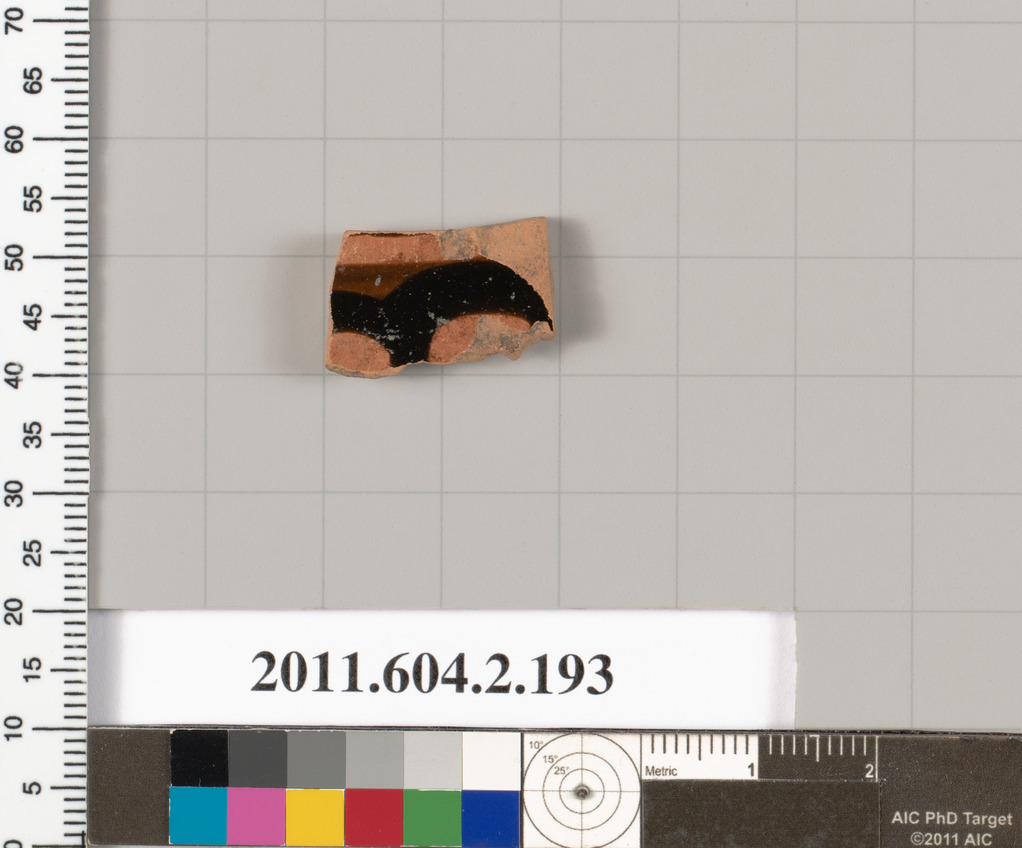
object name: stamnos fragment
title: Terracotta fragment of a stamnos (jar)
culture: greek, attic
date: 500-451 BCE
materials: terracotta